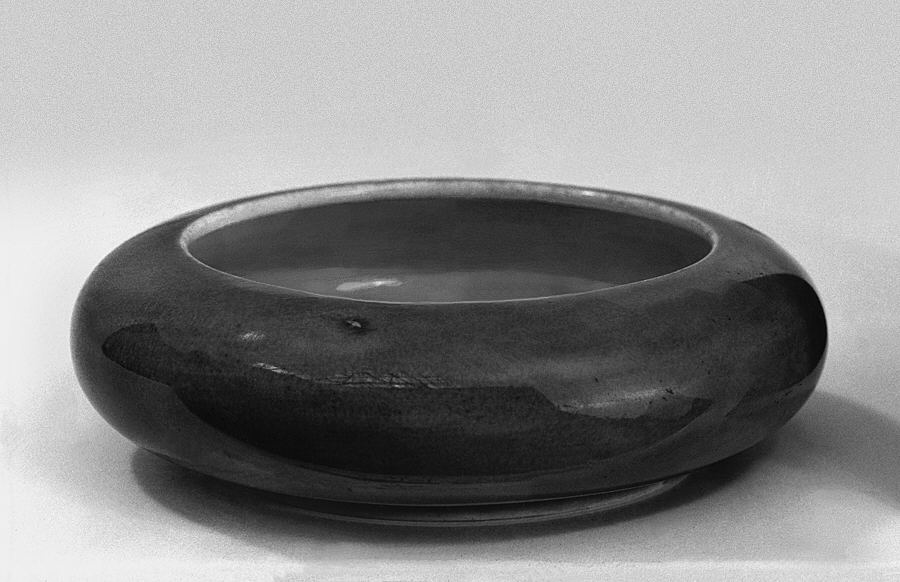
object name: brush washer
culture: chinese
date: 1667-1733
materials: glaze, porcelain